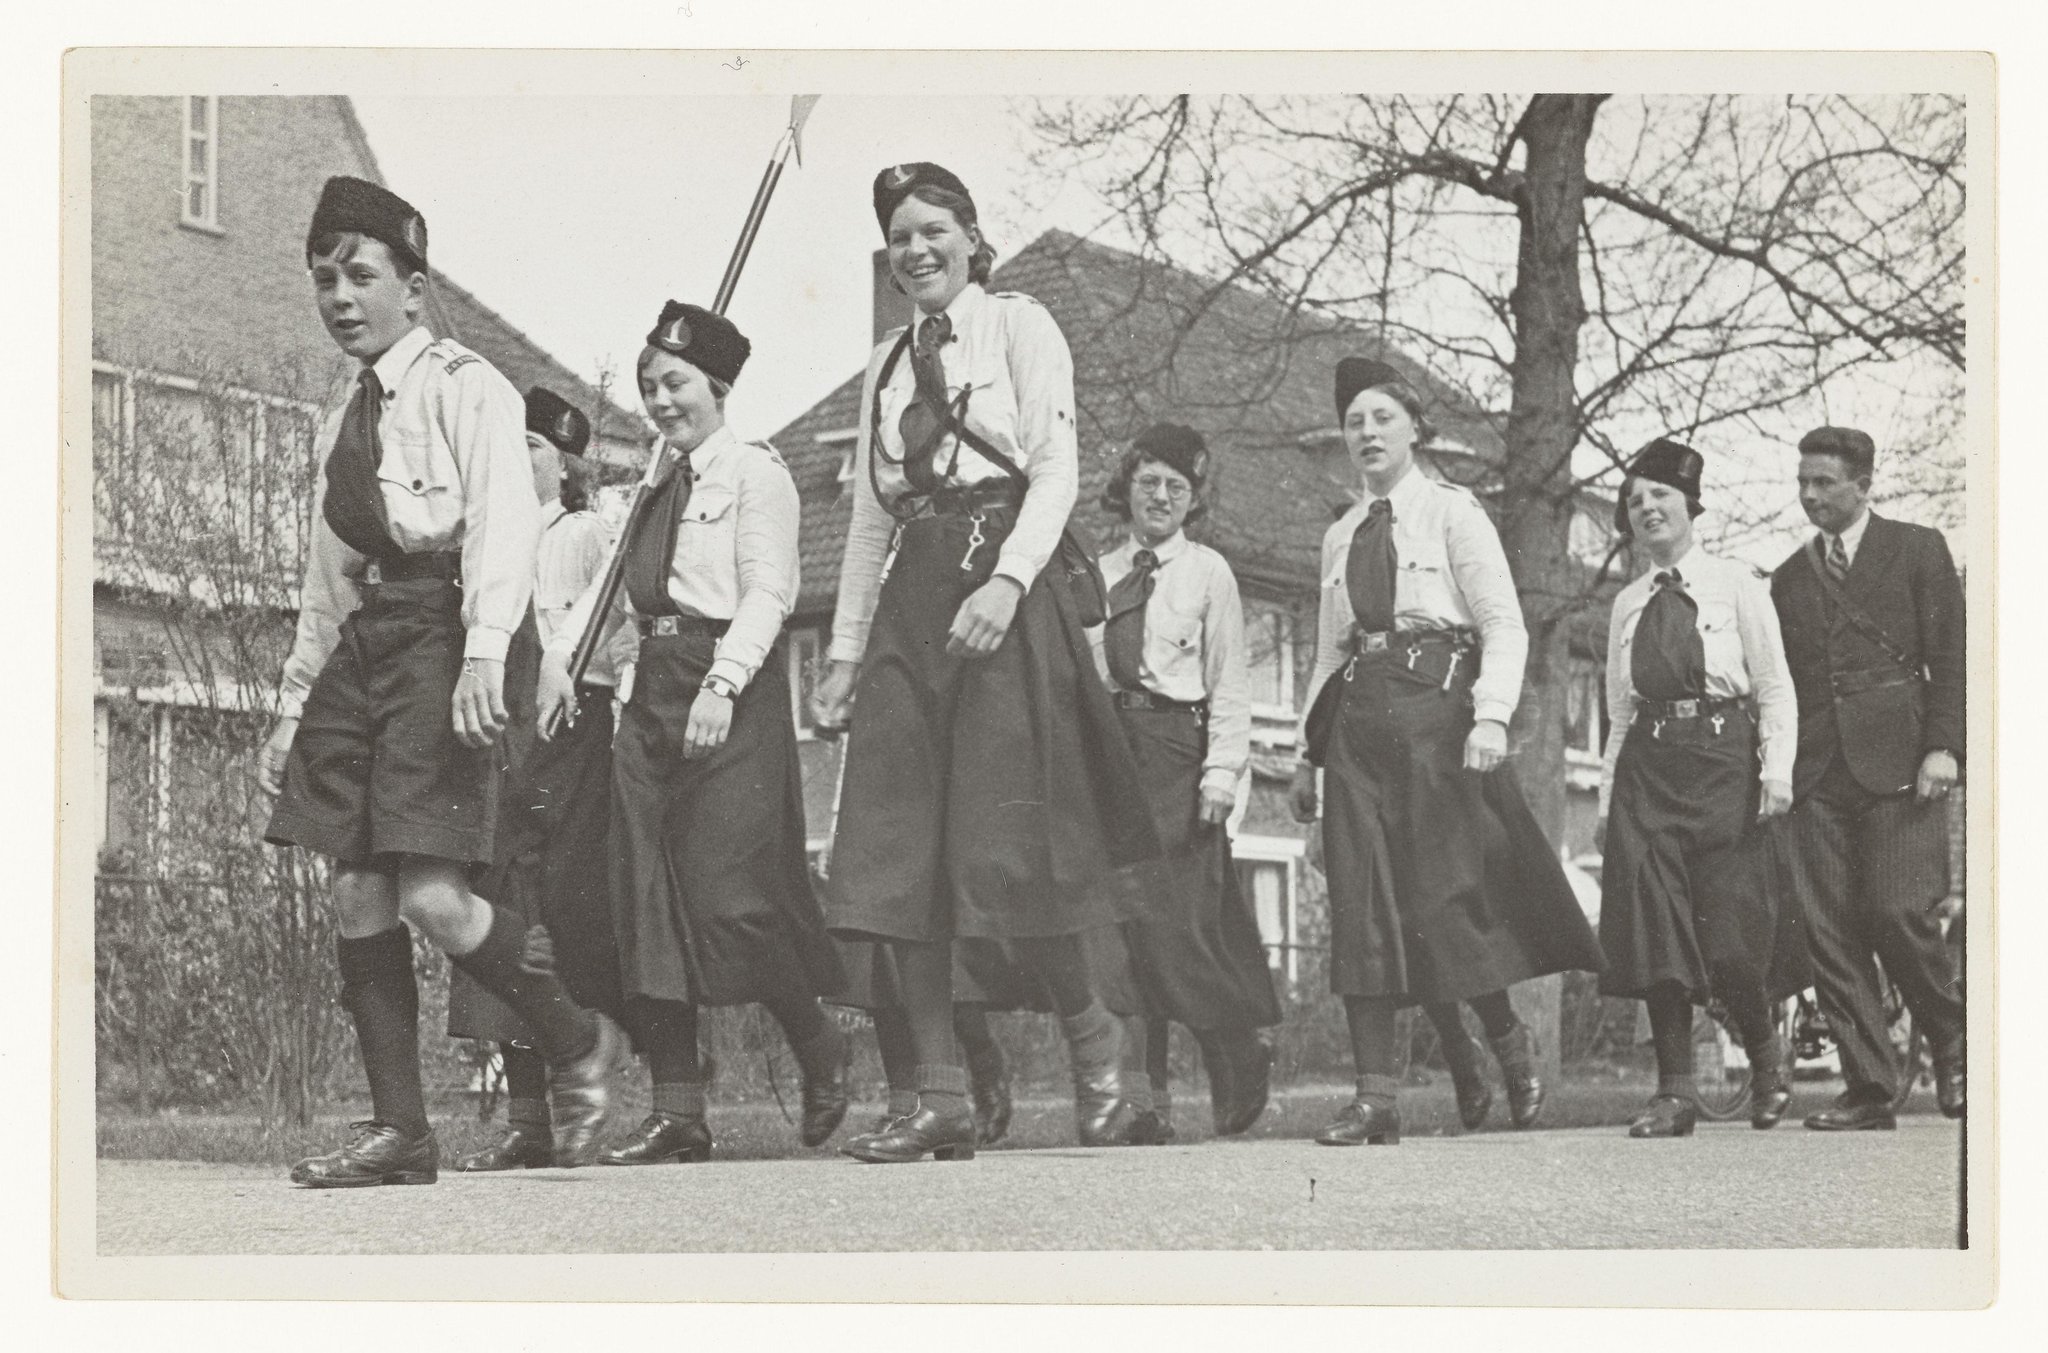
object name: photograph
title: Jeugdstorm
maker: j. otto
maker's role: fotograaf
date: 1935-1937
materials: photographic support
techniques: photography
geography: netherlands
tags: military parade, pageant, netherlands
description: Groep vrouwelijke leden van de Jeugdstorm, met een jongetje voorop, lopen door een straat met villa's. Een van hen draagt een vlag (niet zichtbaar) Allen in uniform.